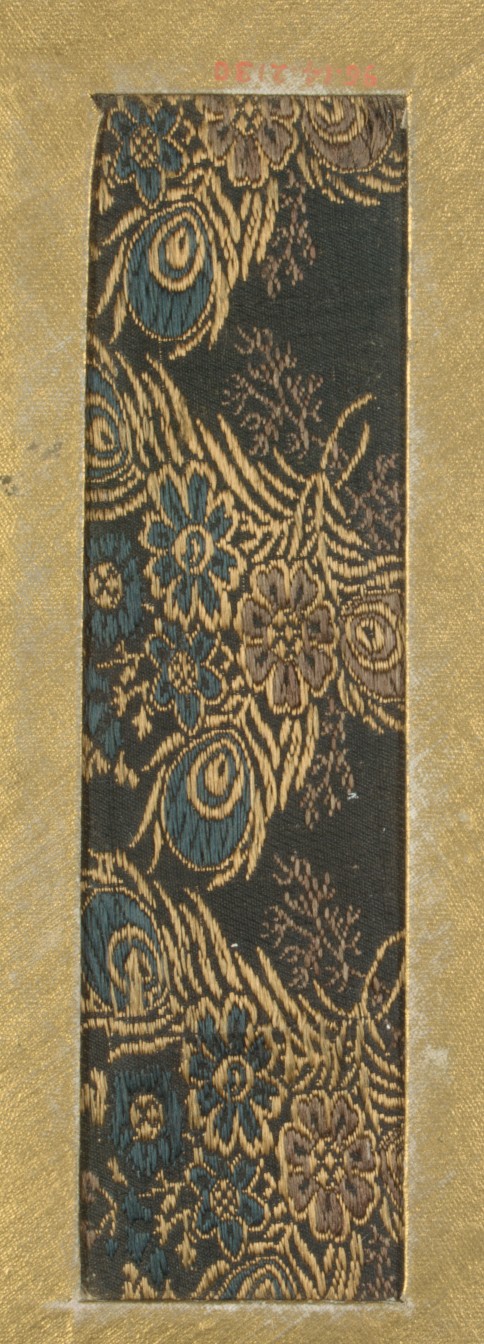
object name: piece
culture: japanese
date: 1701-1900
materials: silk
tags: leaves